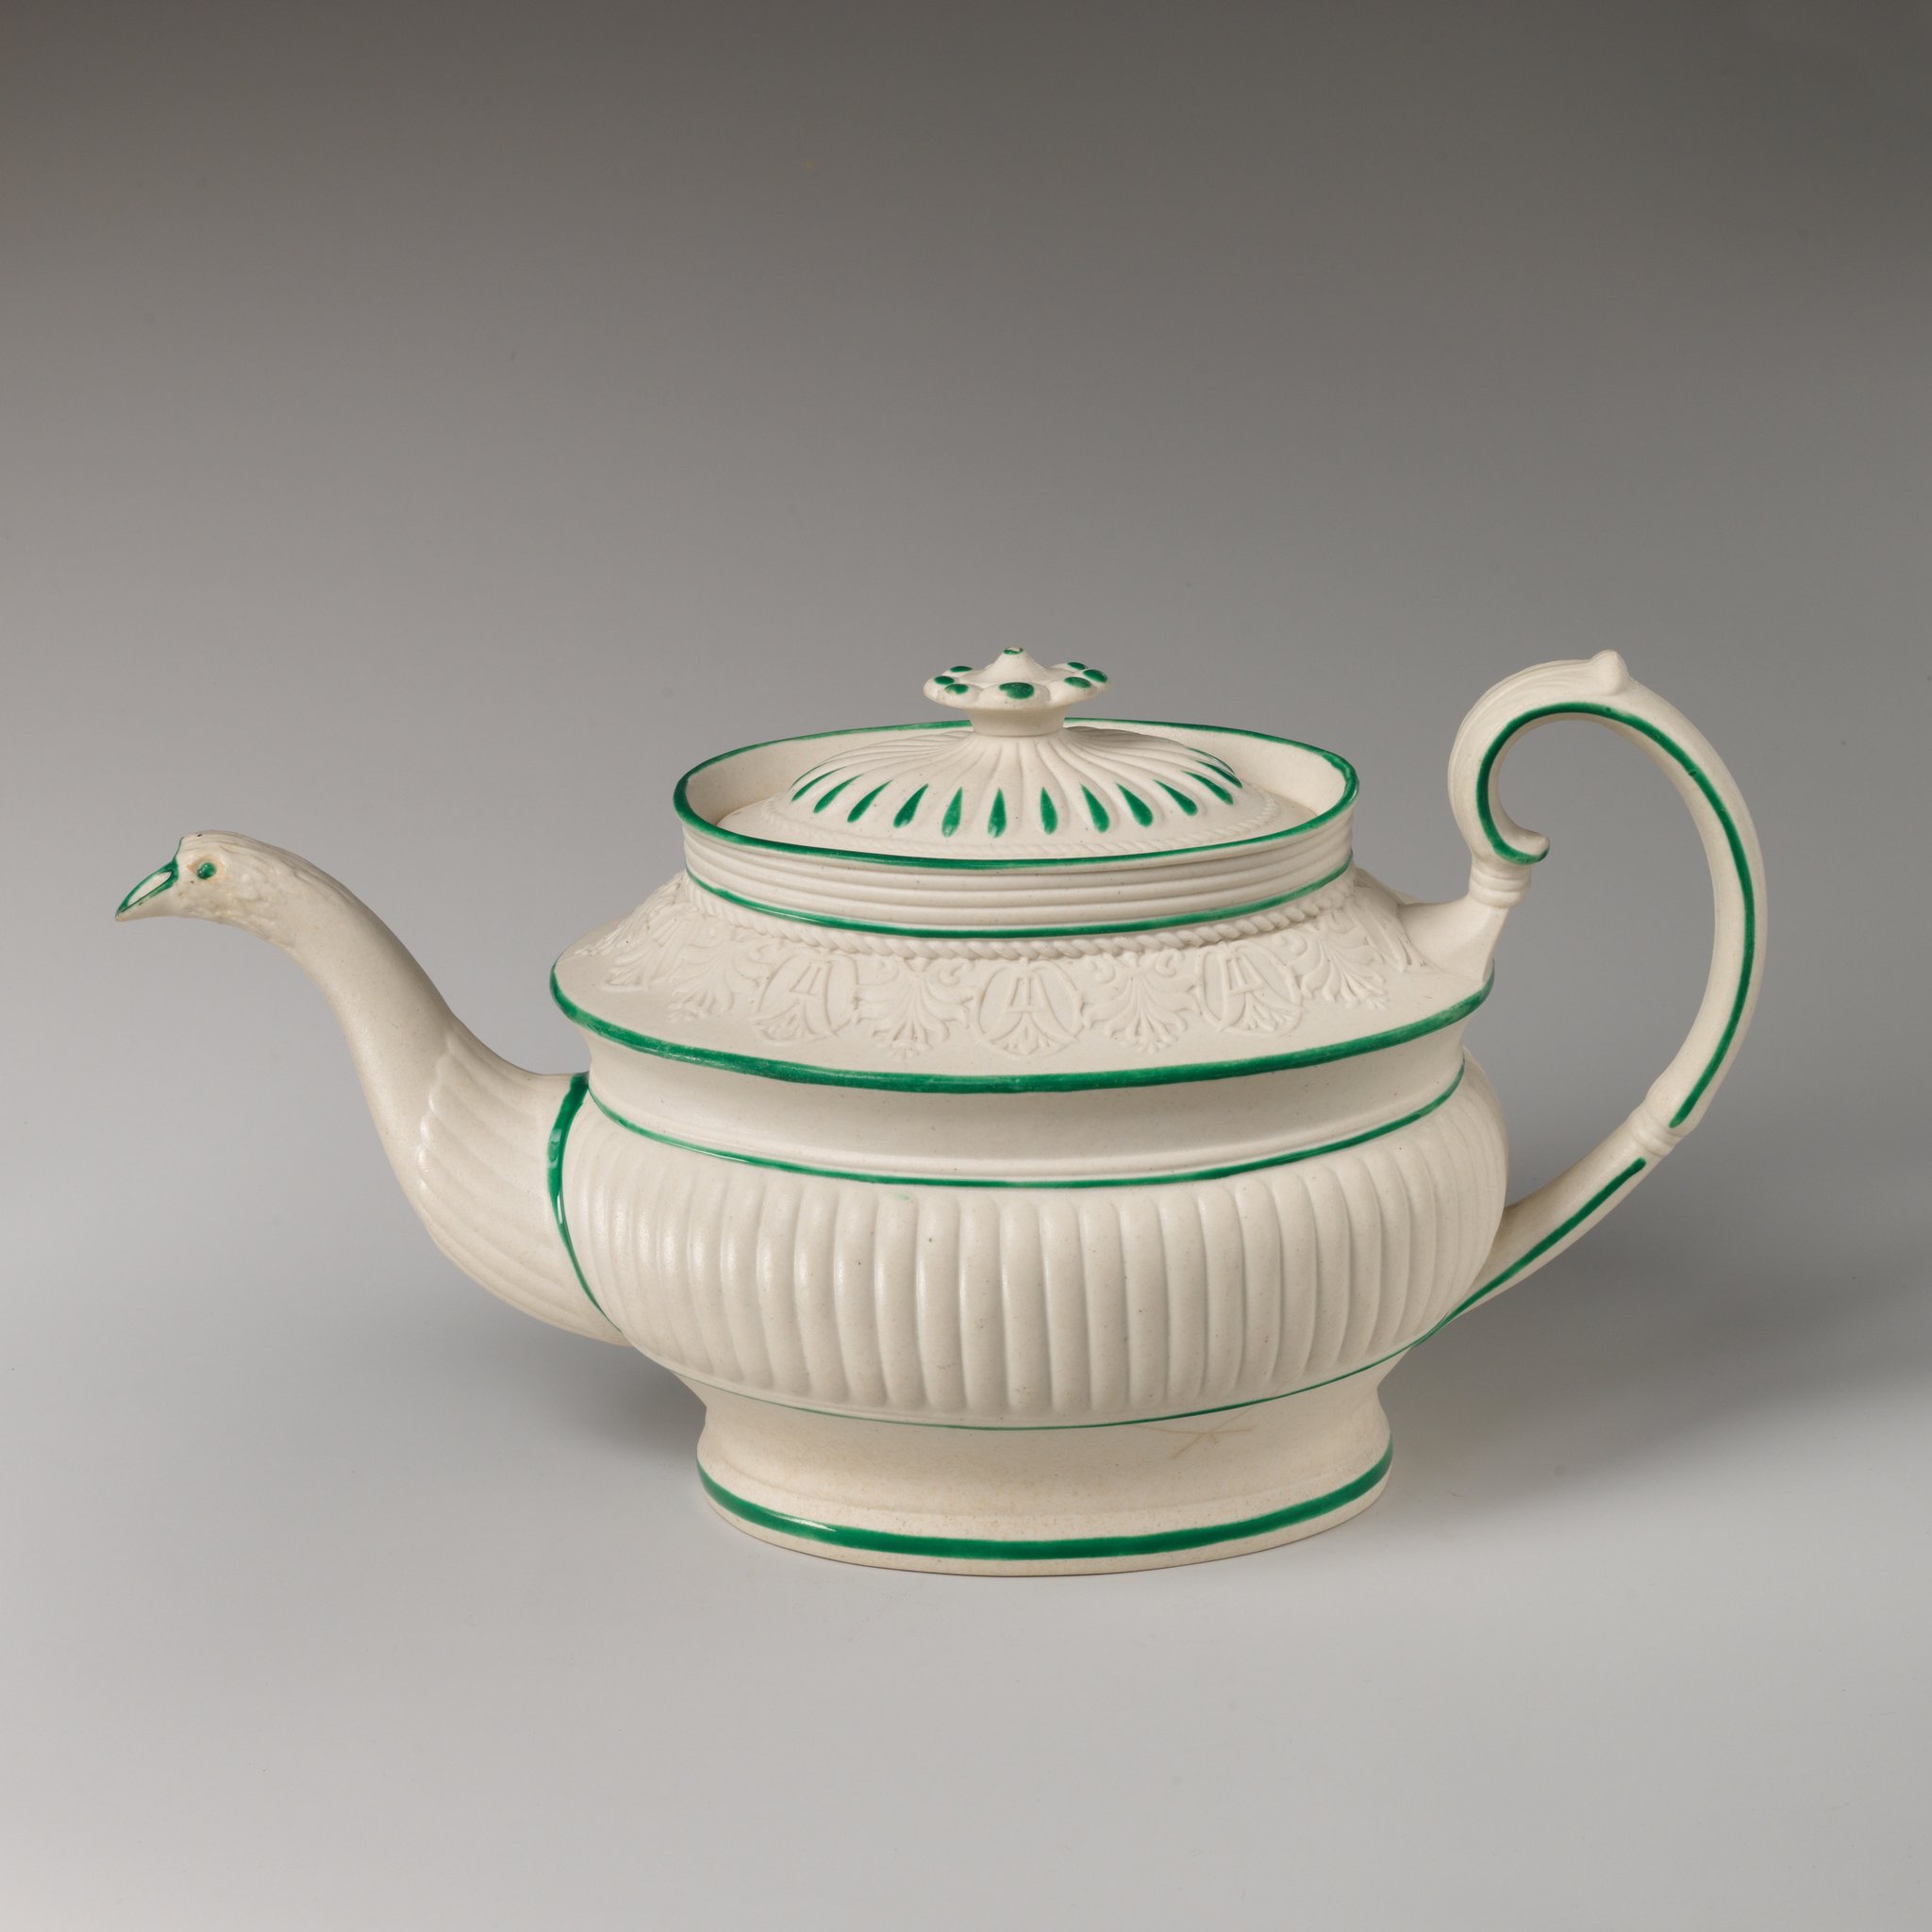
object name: teapot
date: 1800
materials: stoneware